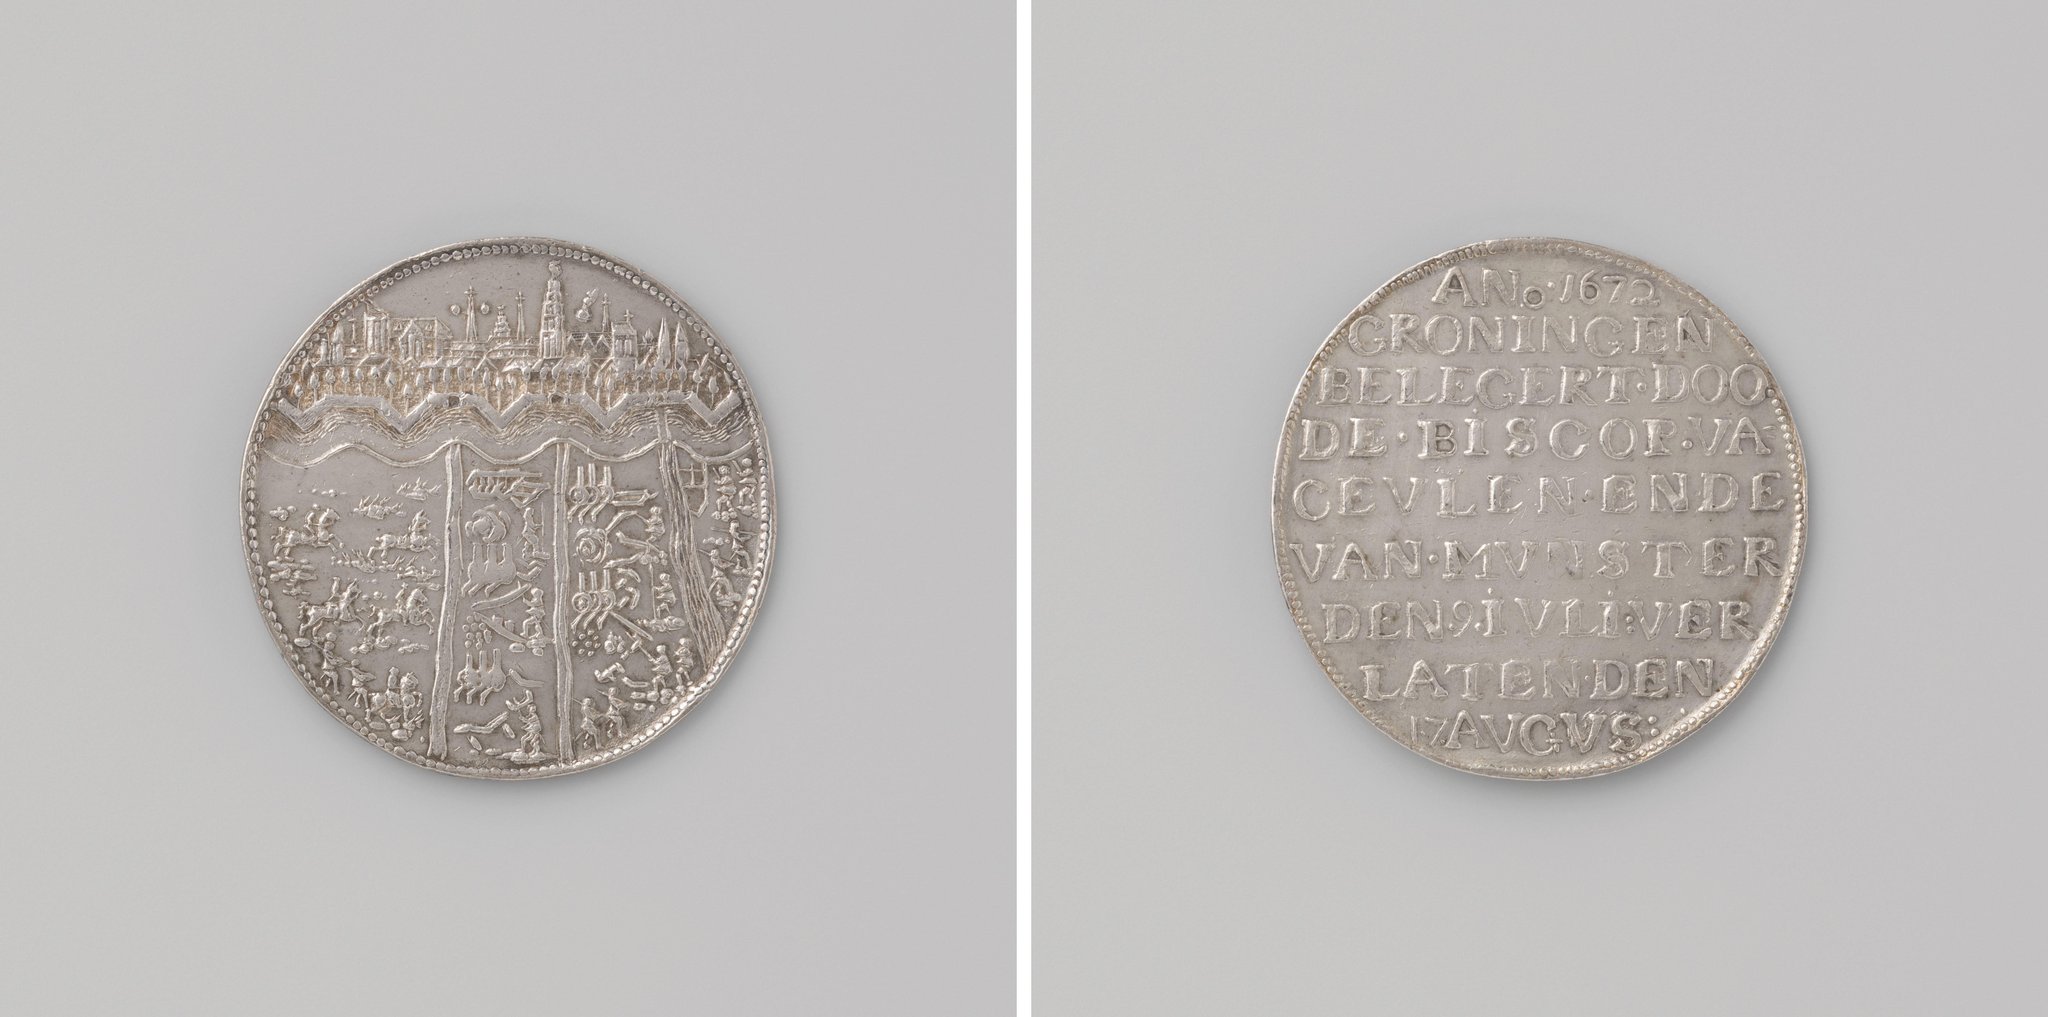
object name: history medal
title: Beleg van Groningen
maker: Anonymous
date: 1672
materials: silver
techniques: striking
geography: netherlands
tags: rampjaar (disaster year)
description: Zilveren penning. Voorzijde: gezicht op stad en belegeraars tijdens beschieting. Keerzijde: opschrift.